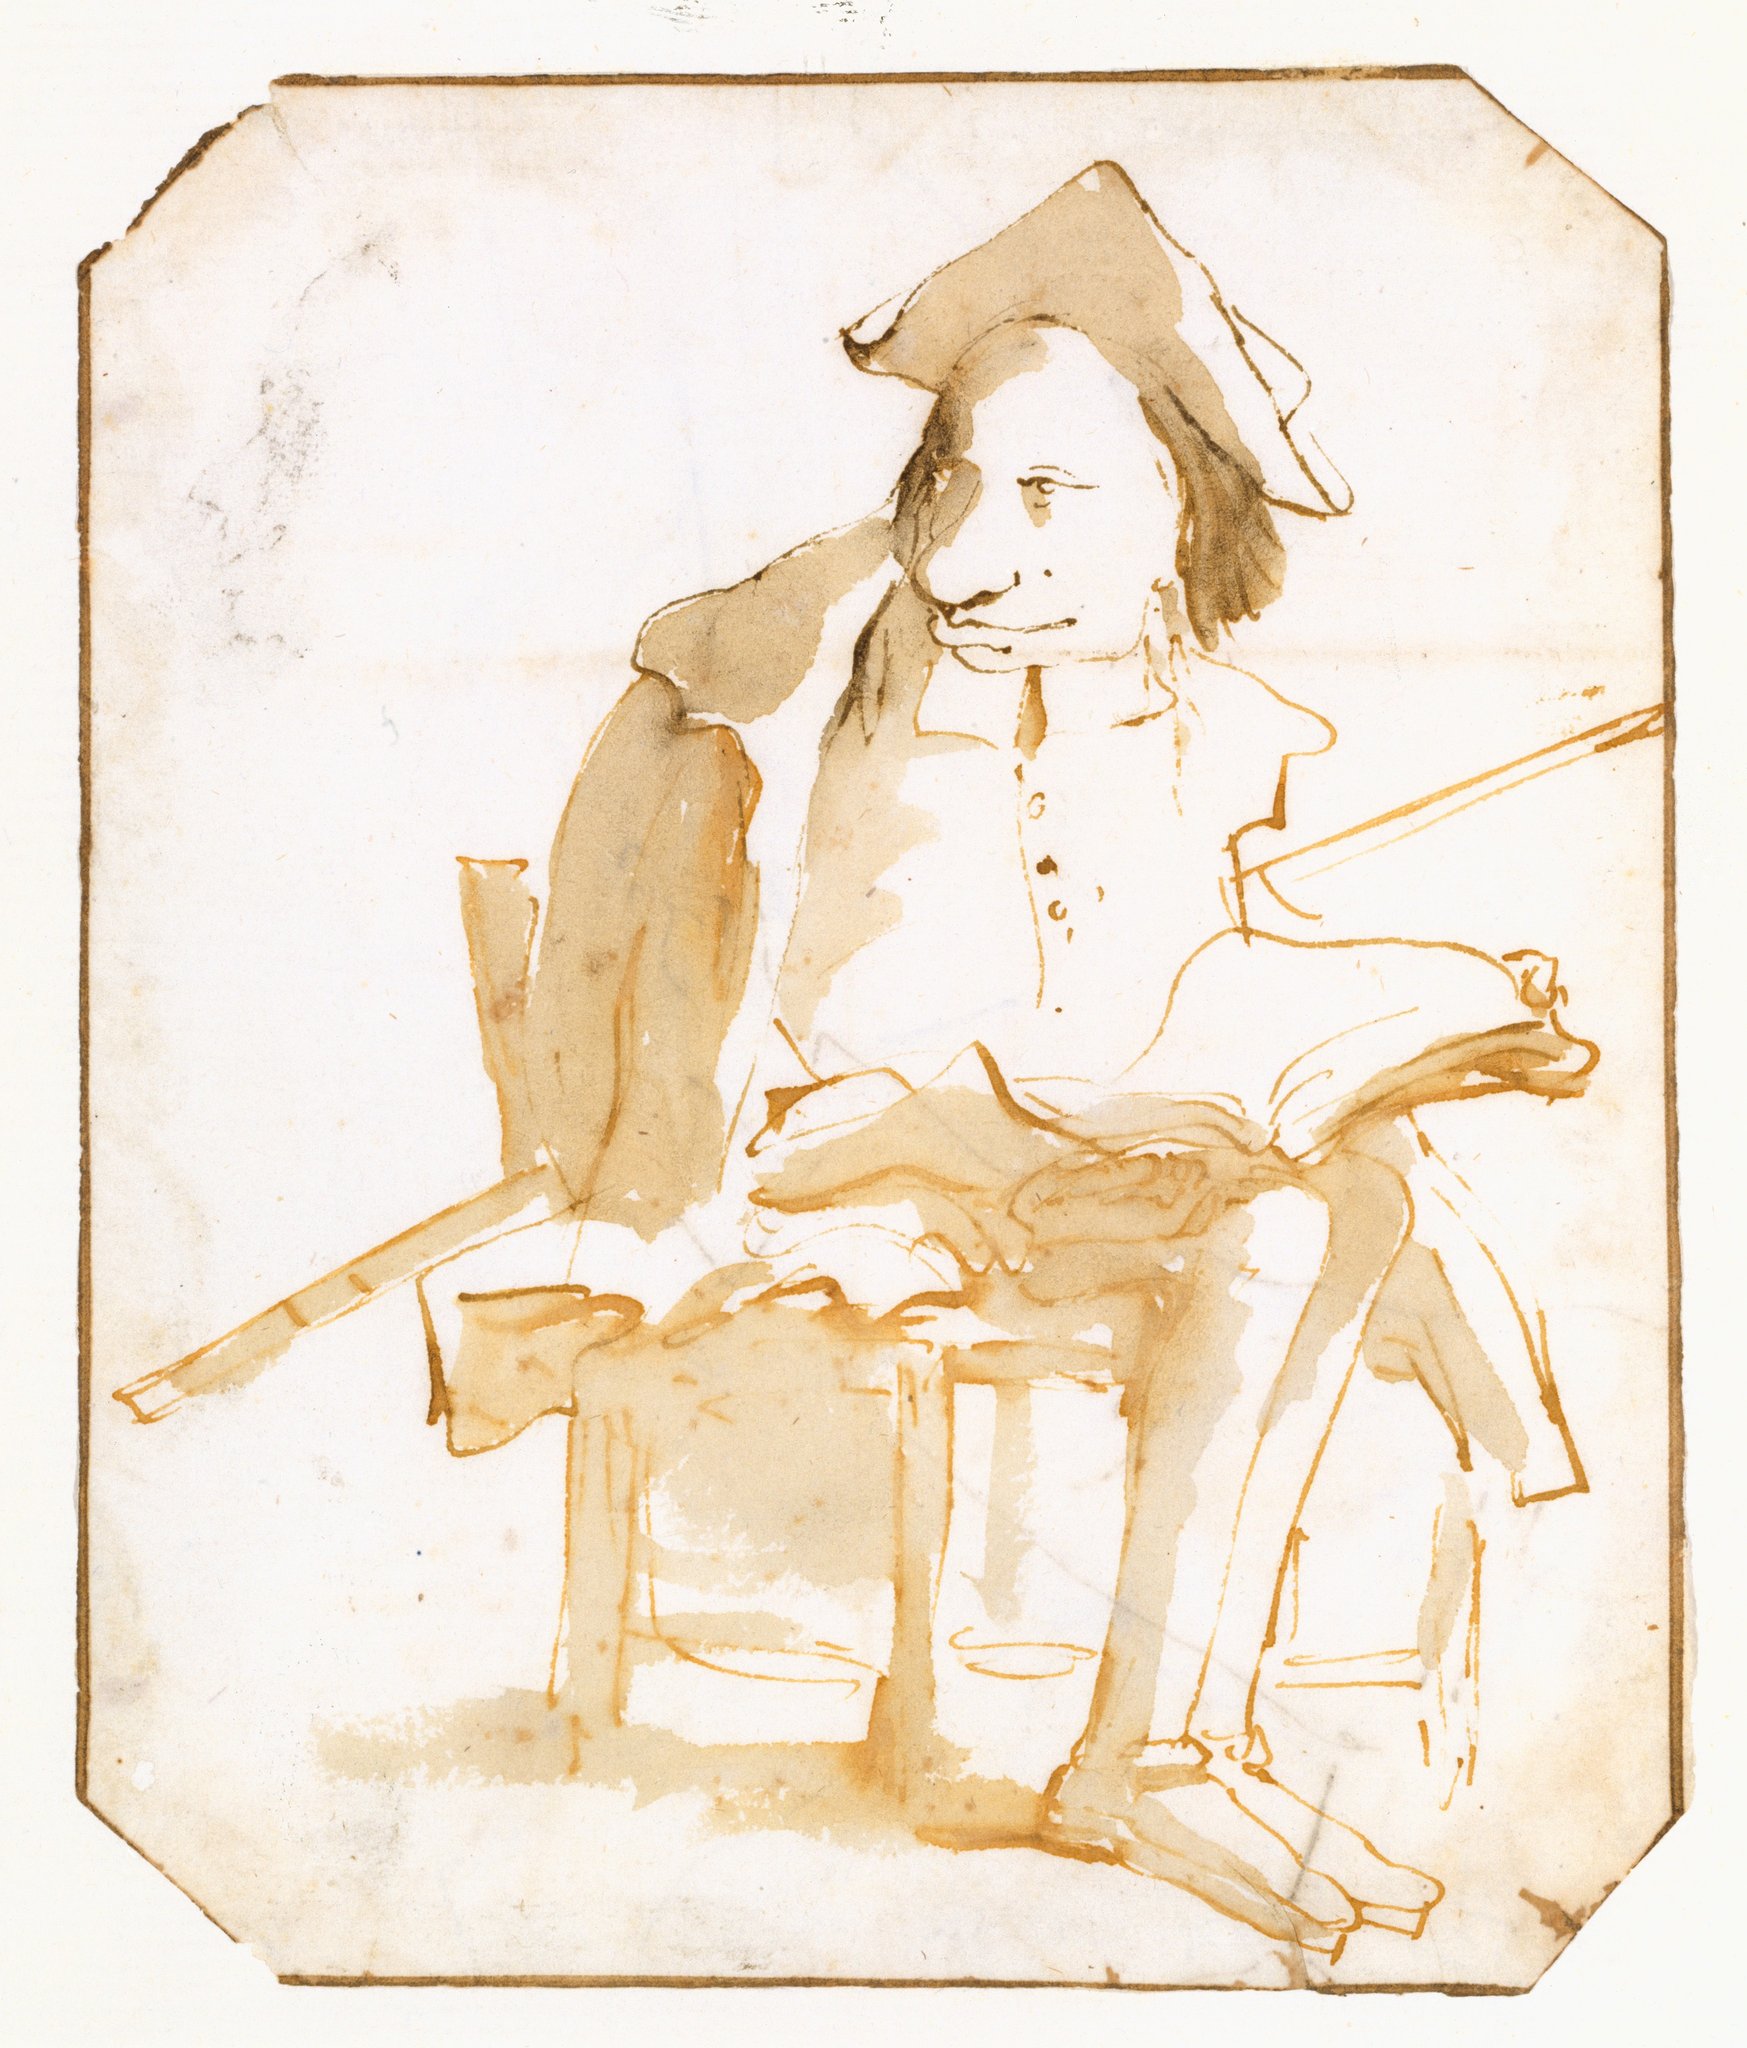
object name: drawing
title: Caricature of a Seated Man with a Book and a Cane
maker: giovanni battista tiepolo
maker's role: artist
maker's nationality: italian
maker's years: 1696-1770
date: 1760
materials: chalk, ink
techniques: pen, wash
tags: men,caricature